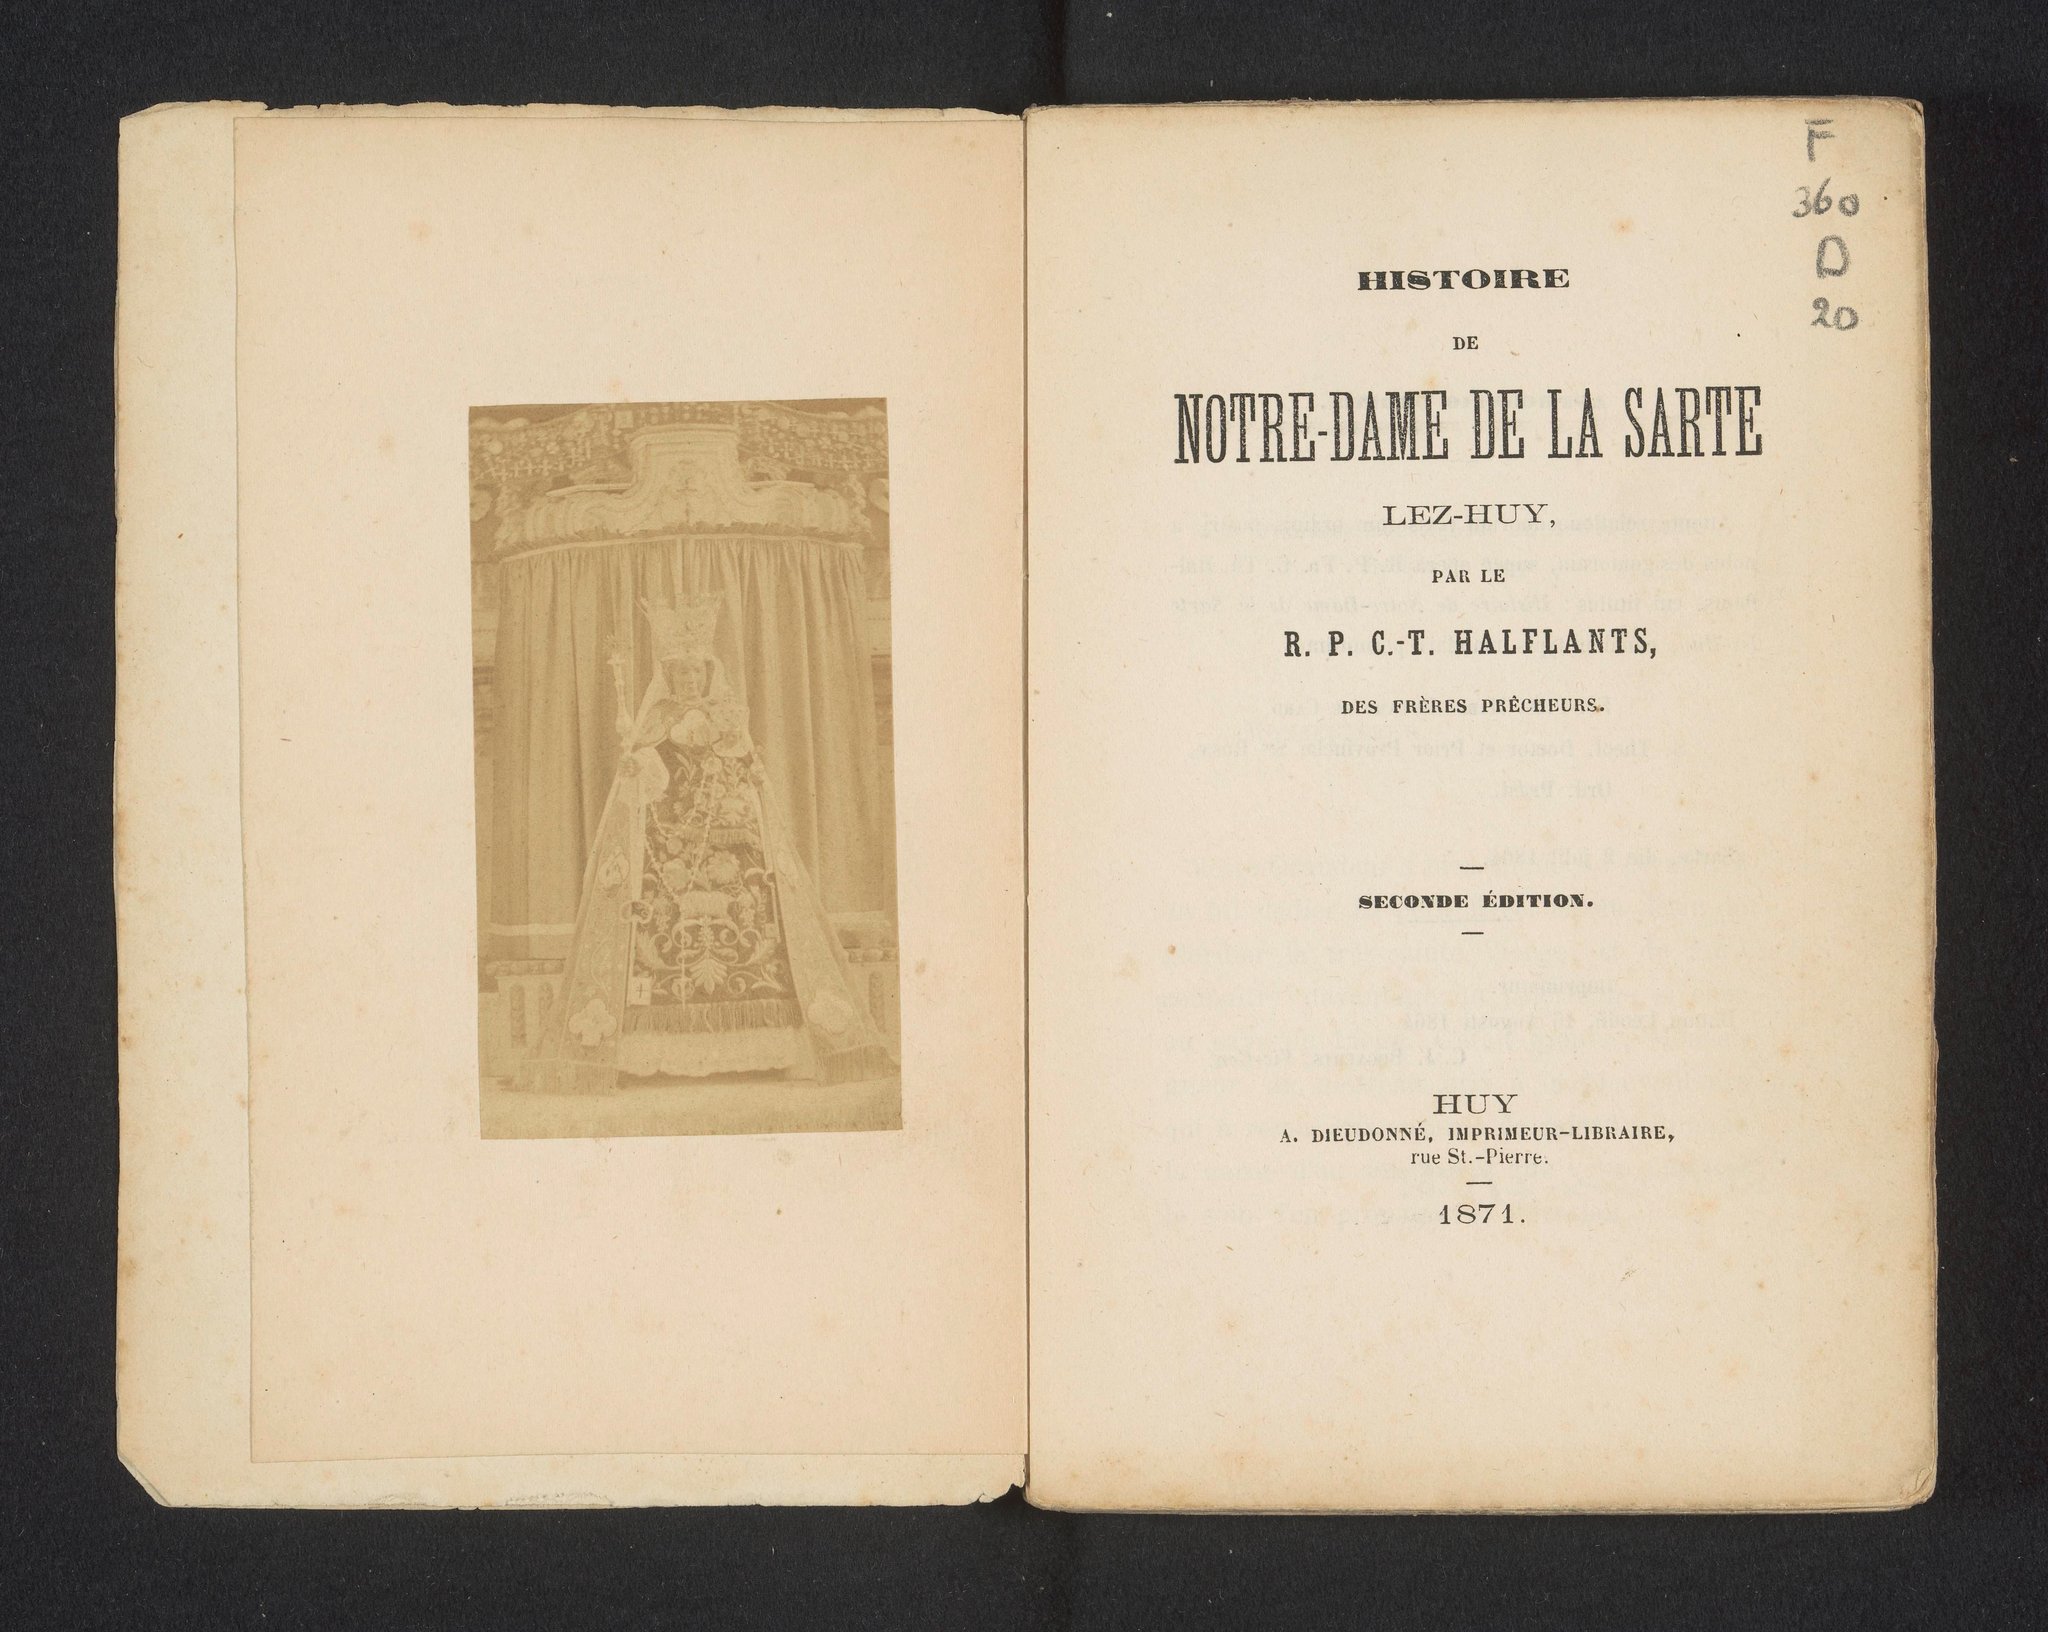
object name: page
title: Portret van een onbekende vrouw als Maria, gekleed in een gedecoreerde mantel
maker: Anonymous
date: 1866-1871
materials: photographic support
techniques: albumen print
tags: historical persons not known by name - bb - woman, 'portraits' of mary